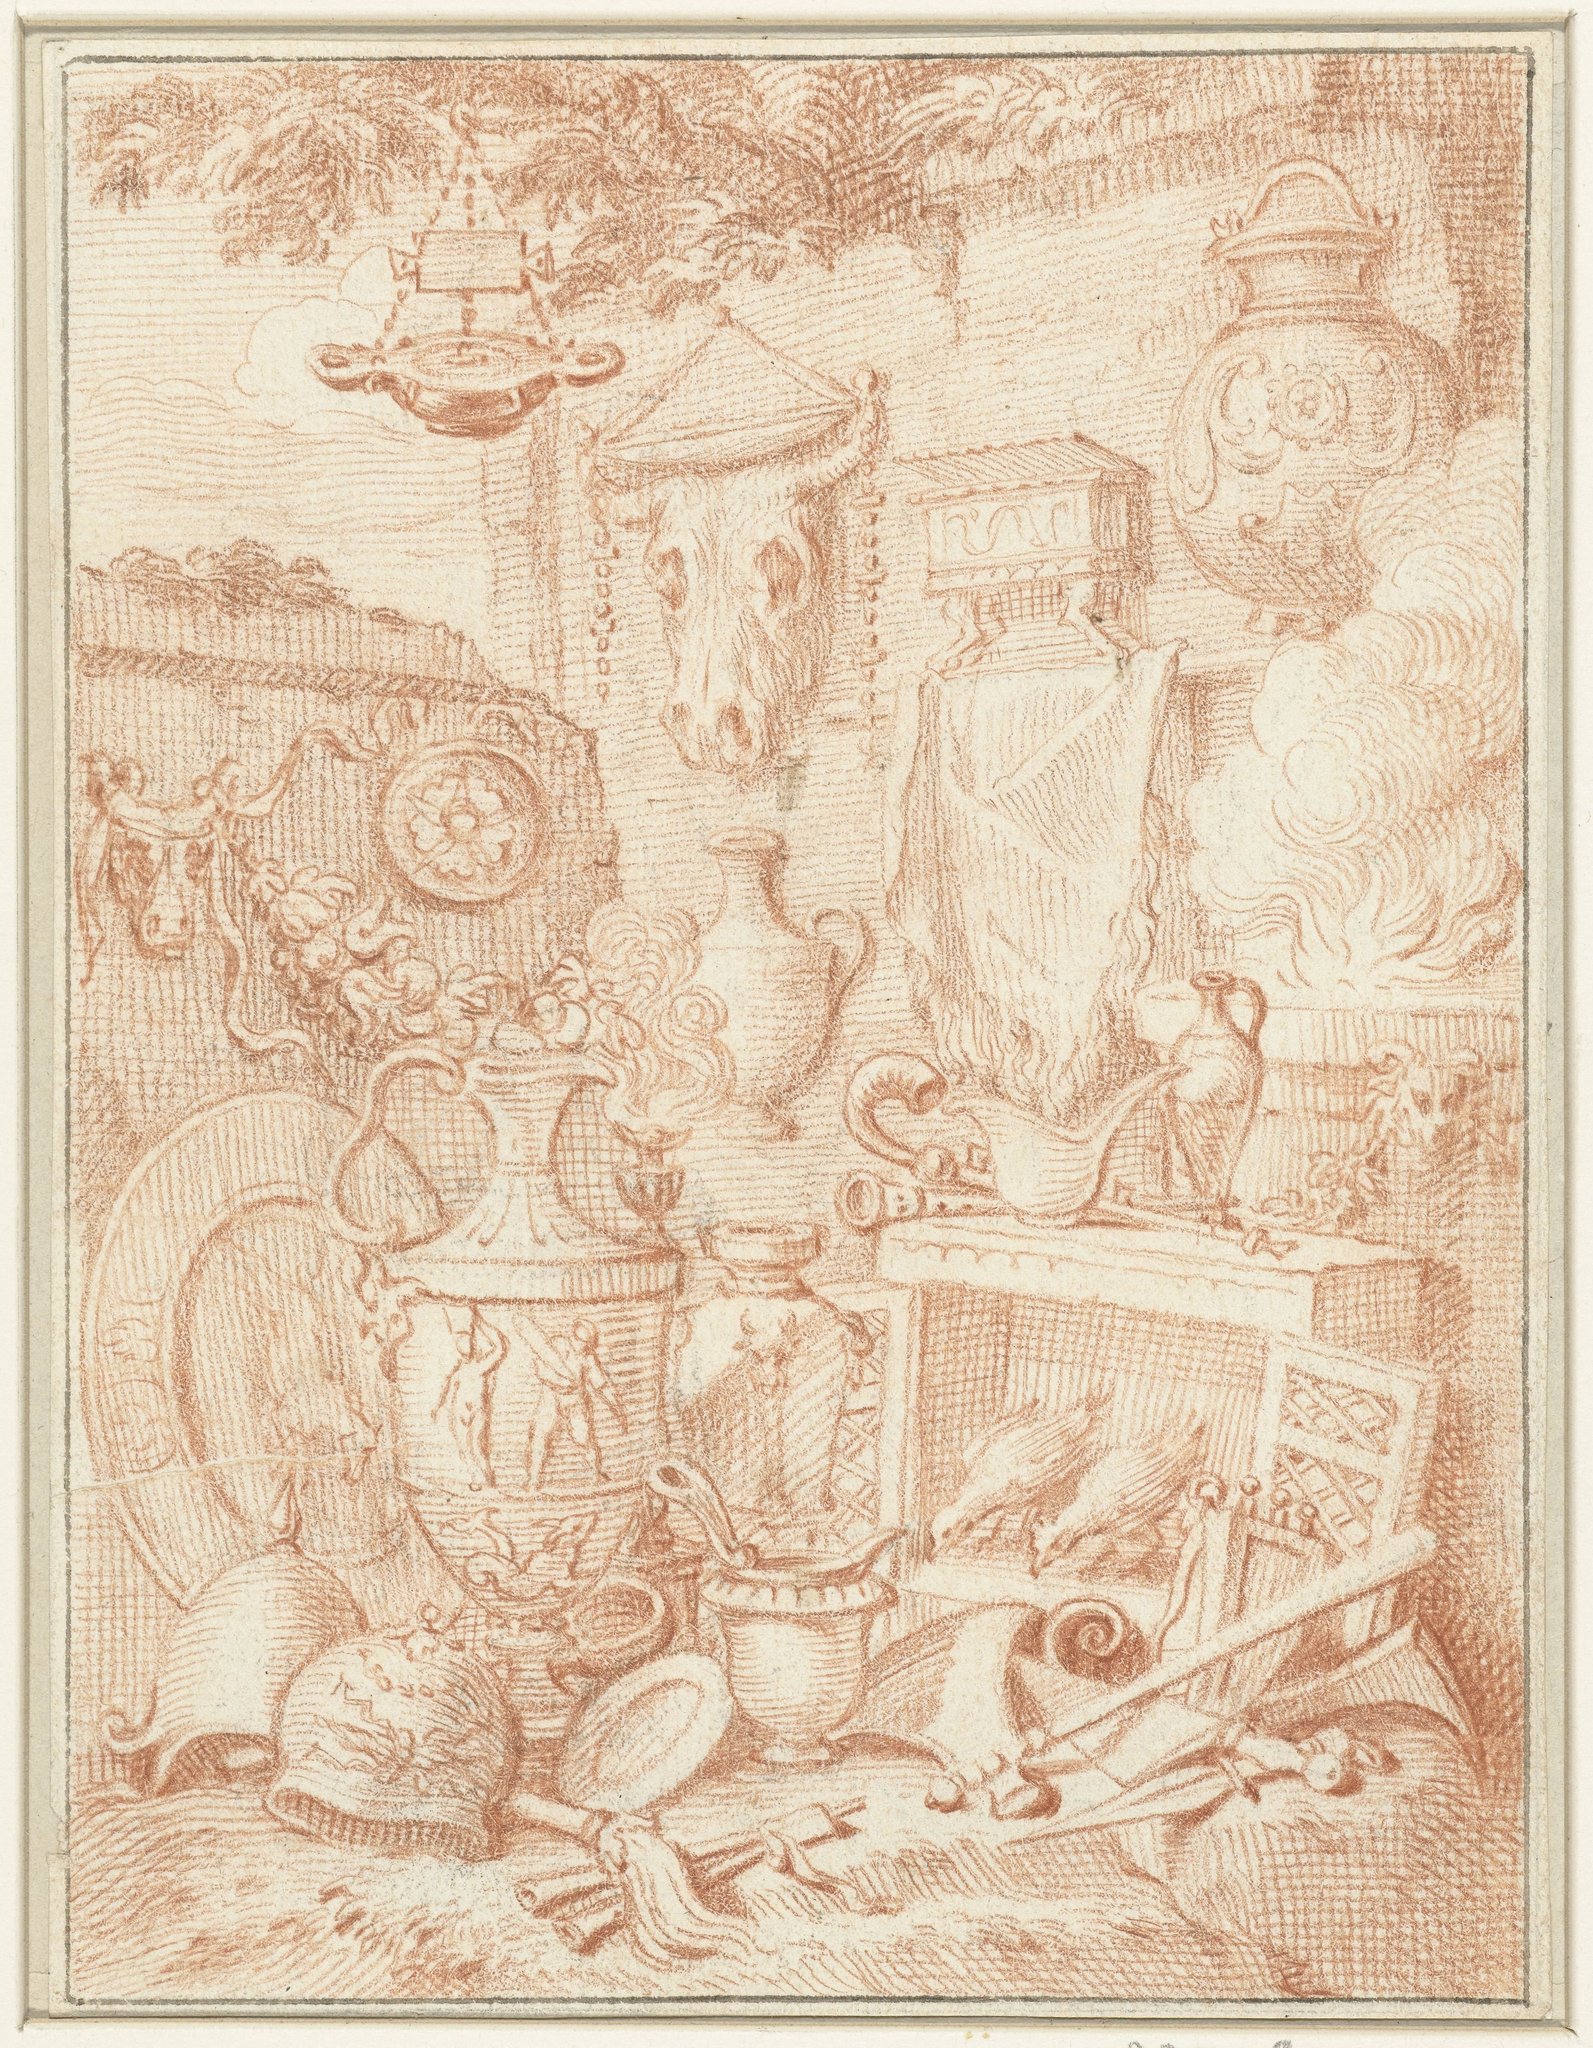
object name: drawing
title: Voorwerpen uit de heidense offerdienst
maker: jacob houbraken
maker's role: draughtsman, print maker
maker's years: 1698-1780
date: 1708-1780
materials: chalk, paper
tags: ritual objects and ritual means ~ non-christian religions, places and objects of worship ~ non-christian religions